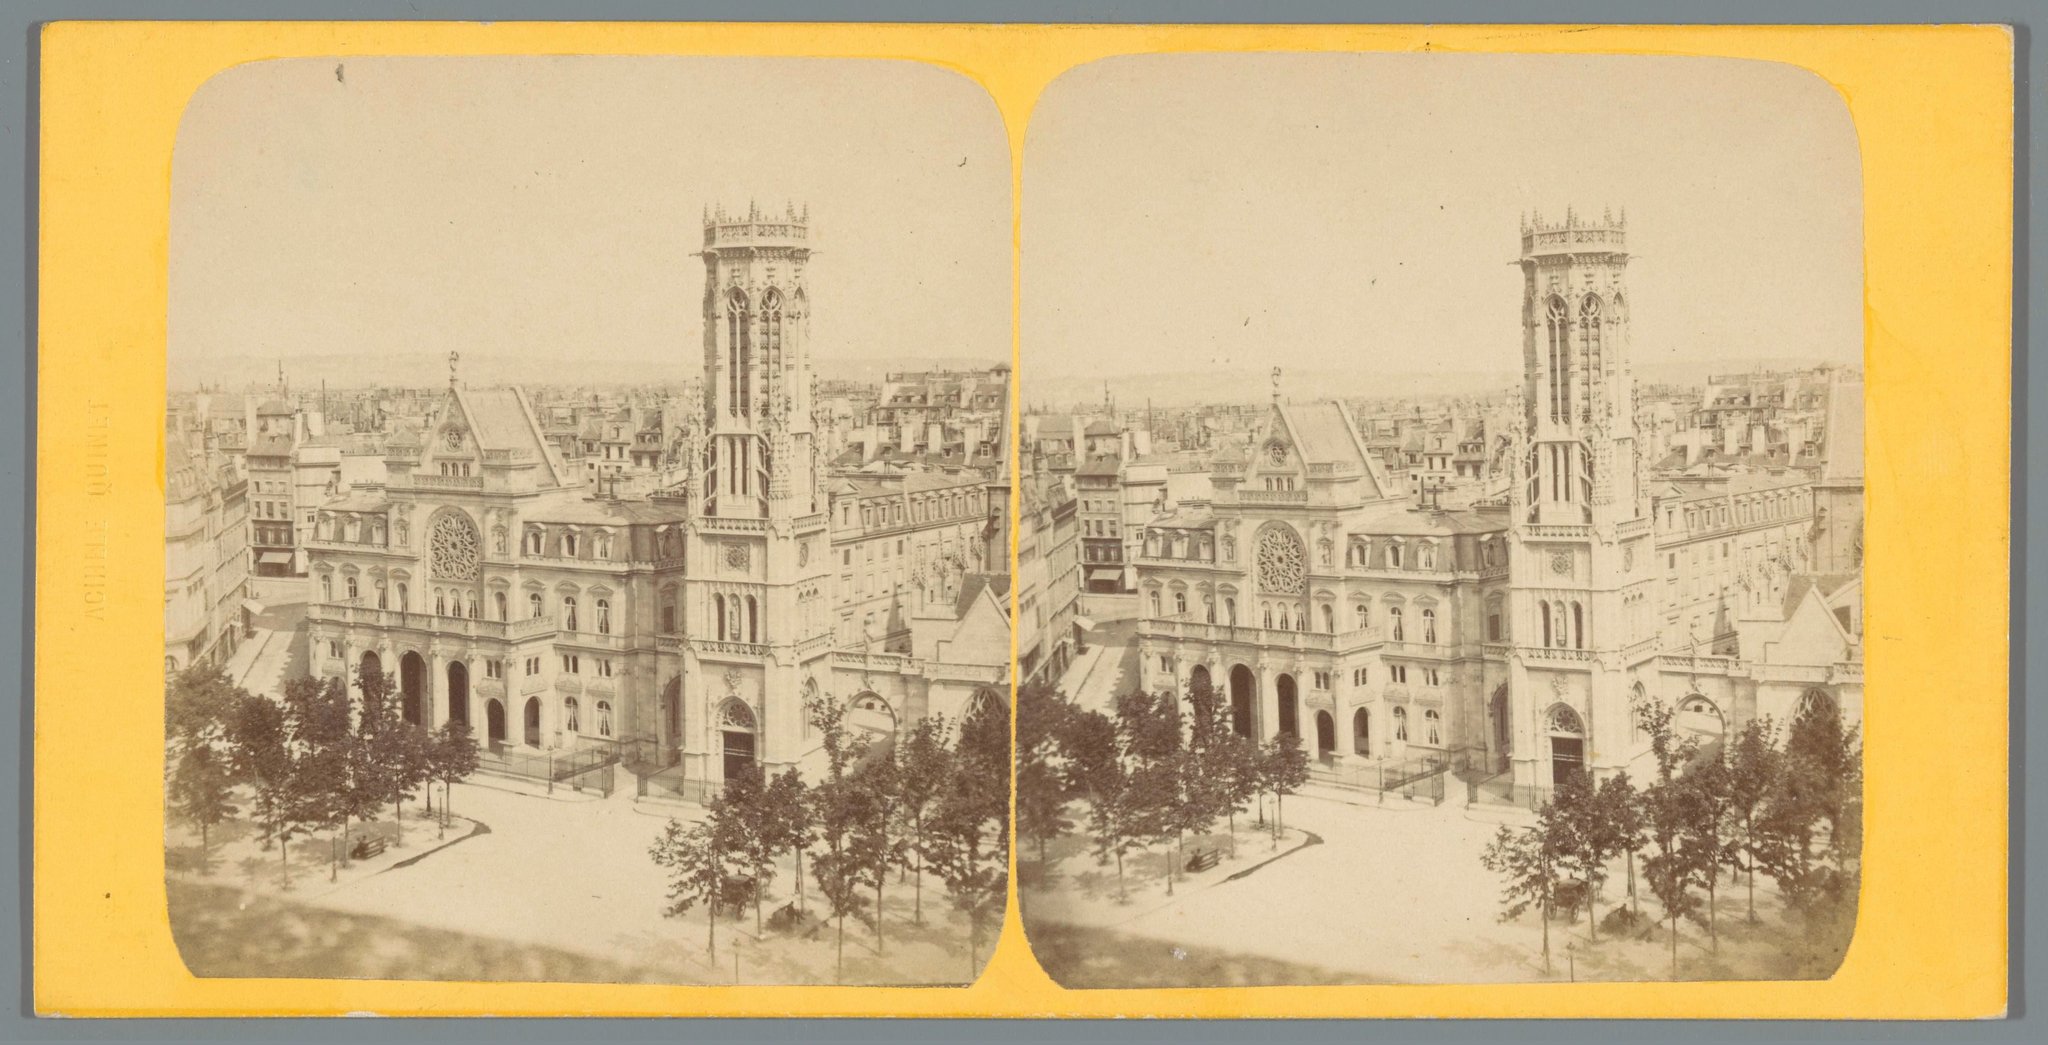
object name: stereograph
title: Gezicht op de Église Saint-Germain-l'Auxerrois in Parijs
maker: achille quinet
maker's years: 1831-1900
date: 1860-1880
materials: cardboard, photographic support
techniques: albumen print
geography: paris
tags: church (exterior)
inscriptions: inscription: ‘Eglise St. Germain l'Auxerrois’